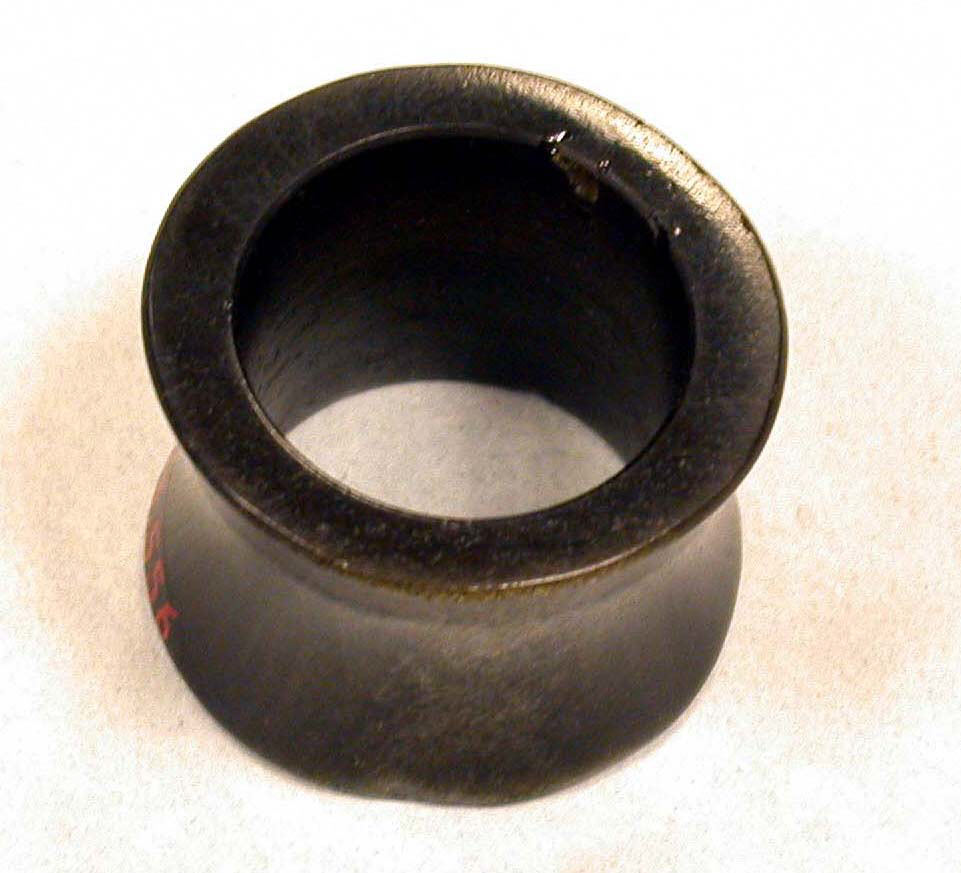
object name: ear spool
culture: mexican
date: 1501-1600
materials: obsidian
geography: mexico